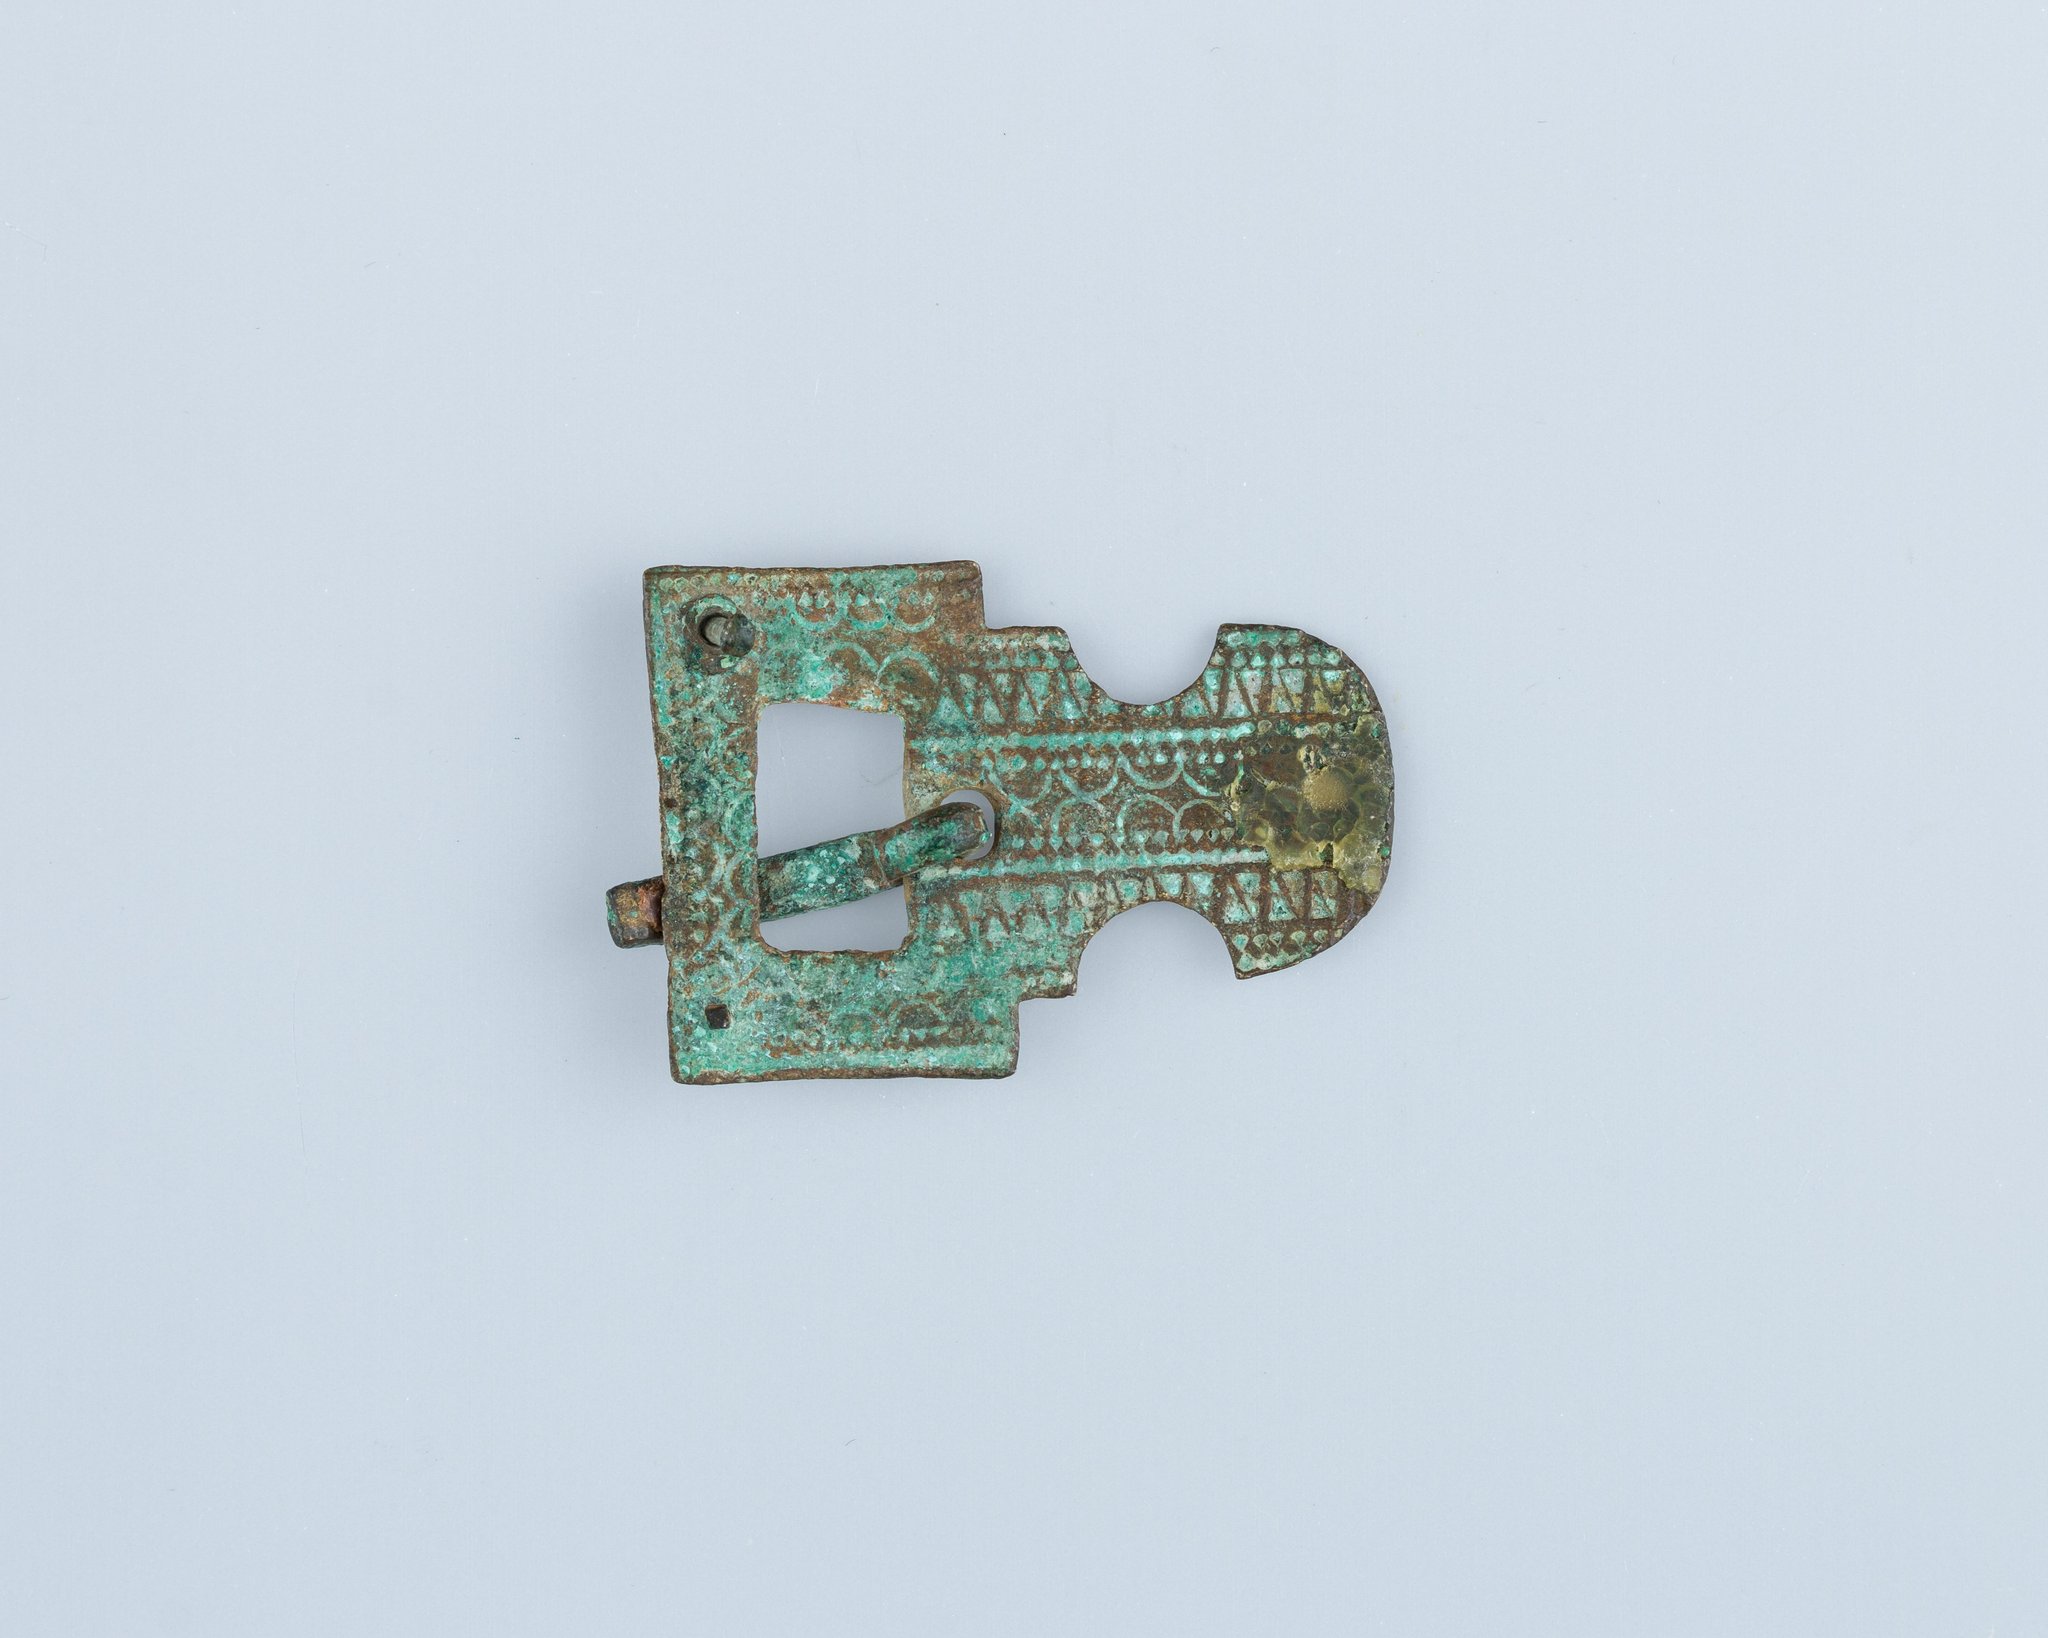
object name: buckle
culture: ibero-roman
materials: bronze, patina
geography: spain or portugal